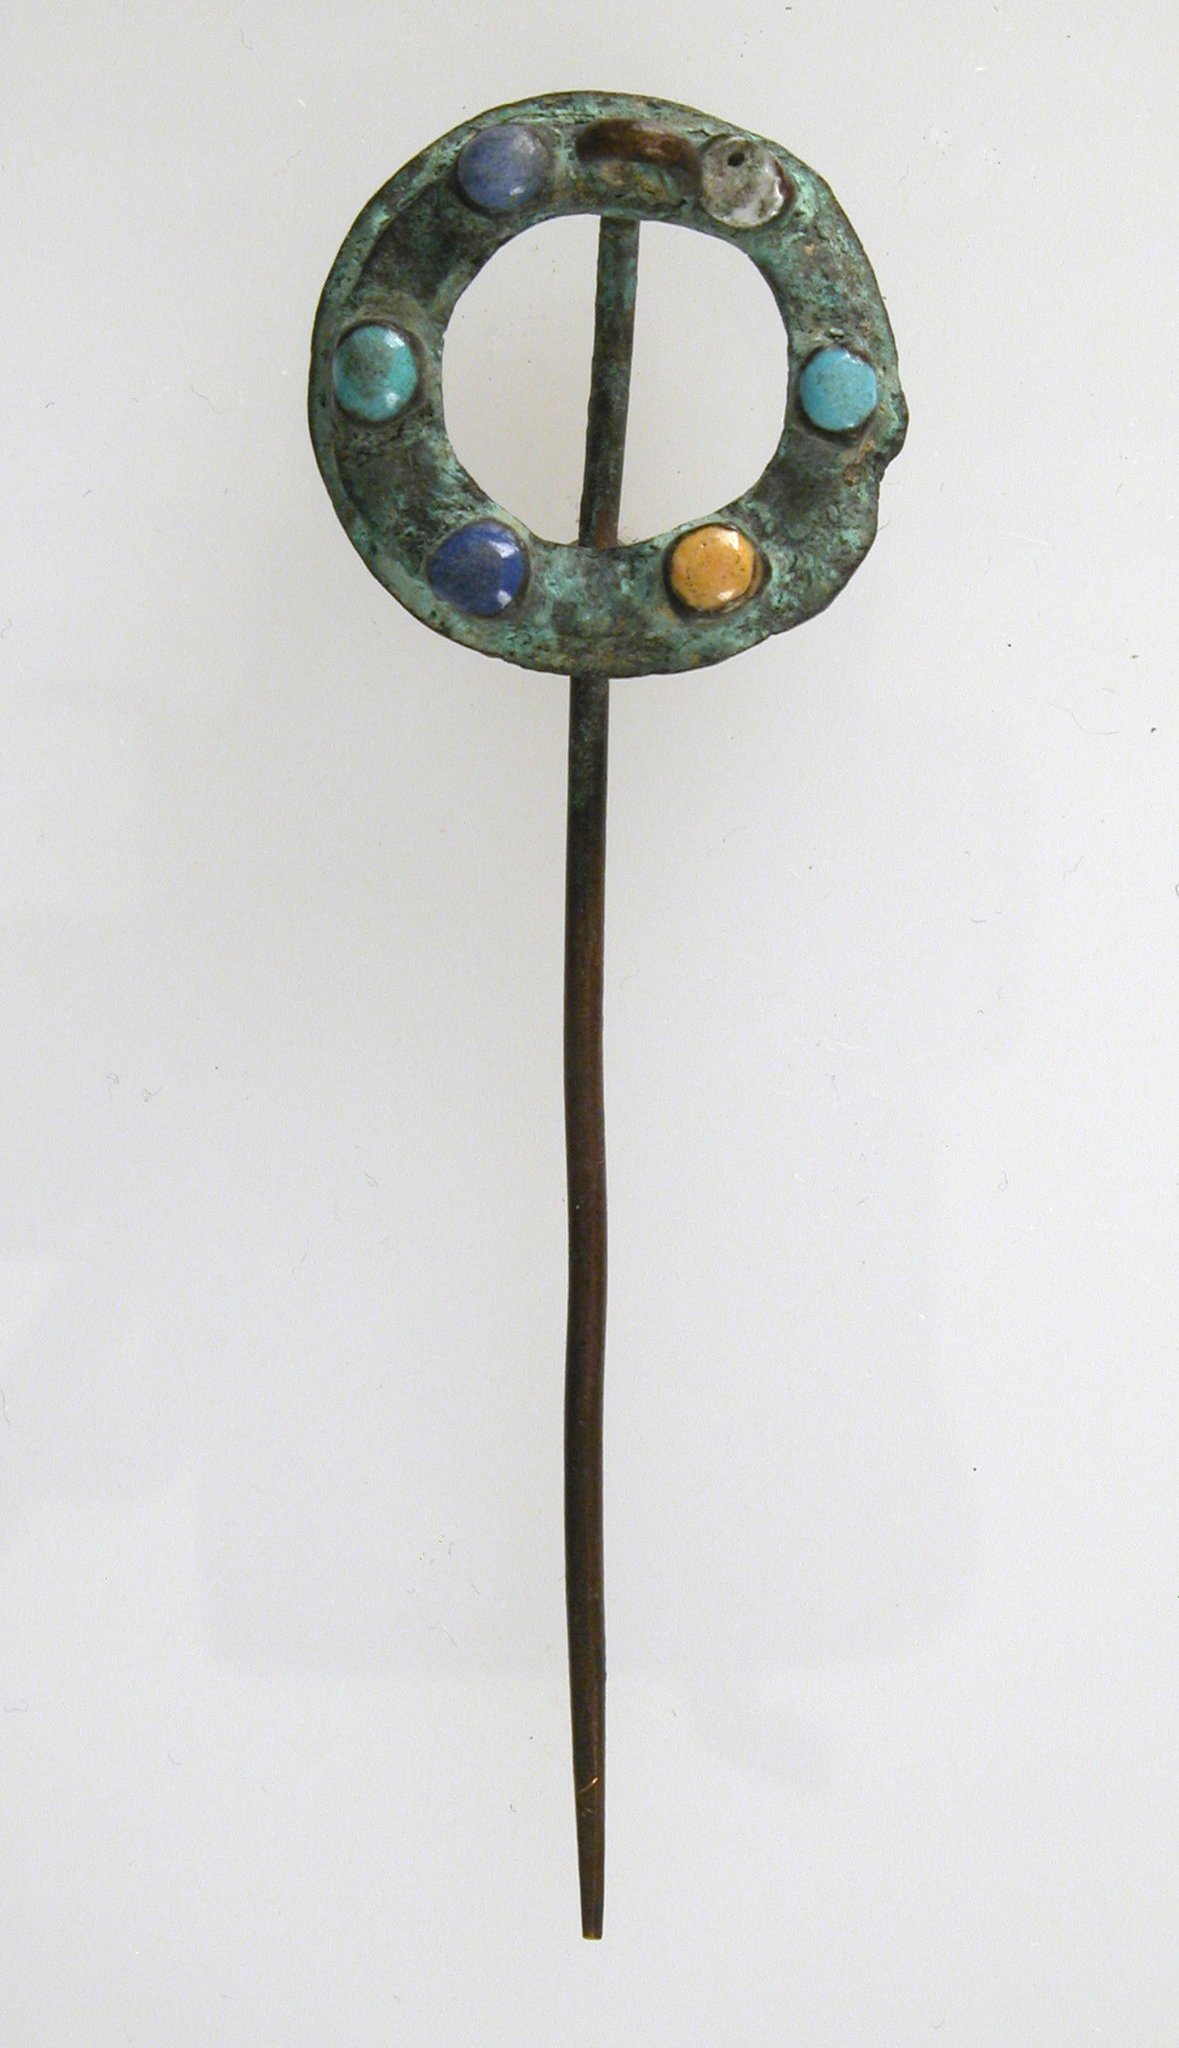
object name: pin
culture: roman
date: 201-400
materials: copper alloy, glass